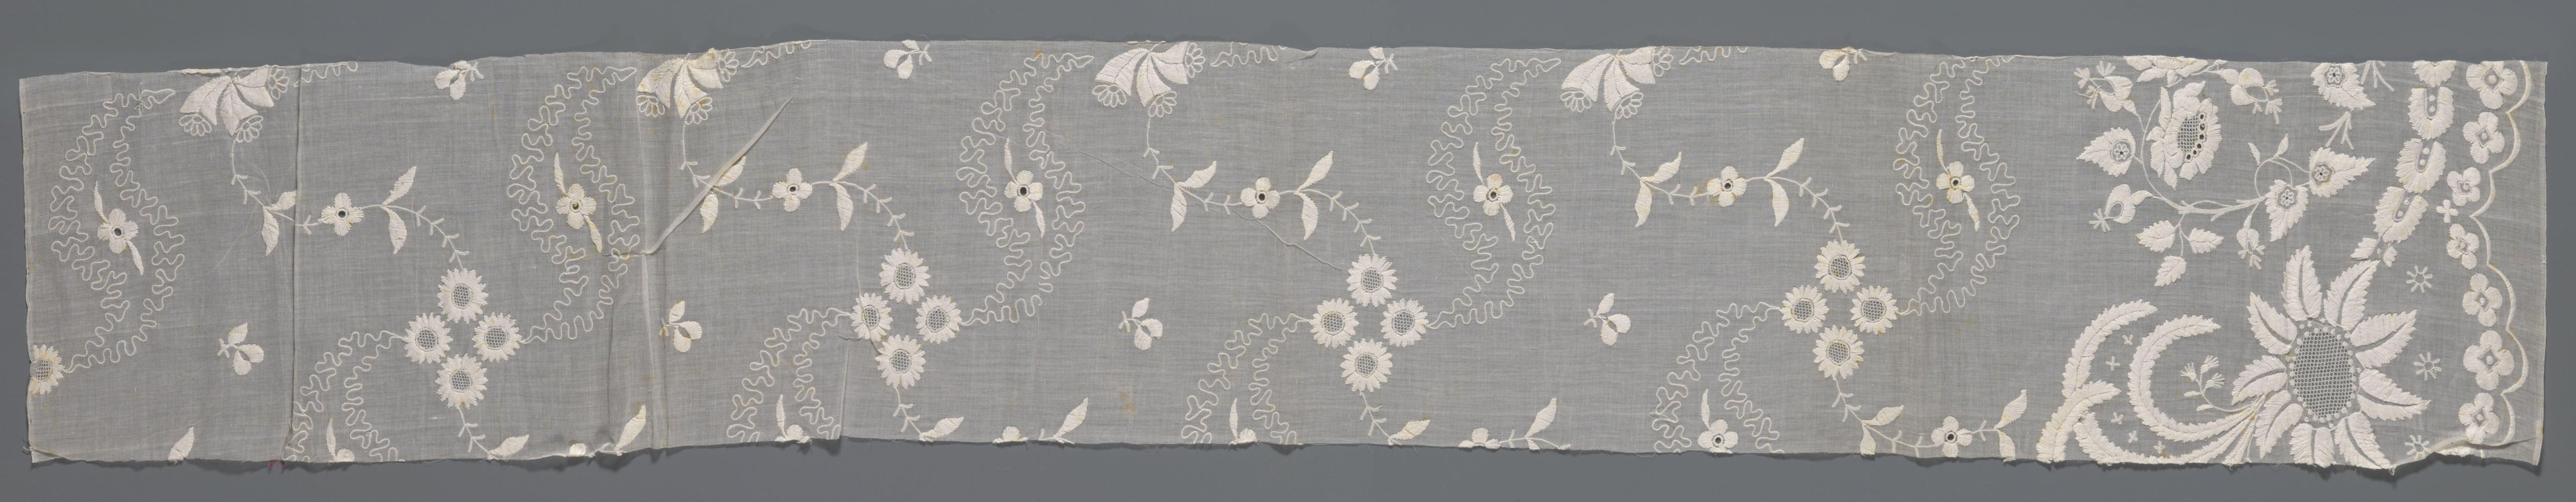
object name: curtain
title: Fragment van een gordijn van glasbatist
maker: Anonymous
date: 1800-1874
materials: textile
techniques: stopwork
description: Fragment van een gordijn van glasbatist, versierd met tule doorstopborduursel (wit op wit). Met briefje: 'Deze gordijnen zijn gebruikt voor de ramen van het kleedkamertje van H.M. de Koningin 16 juli 1874'.